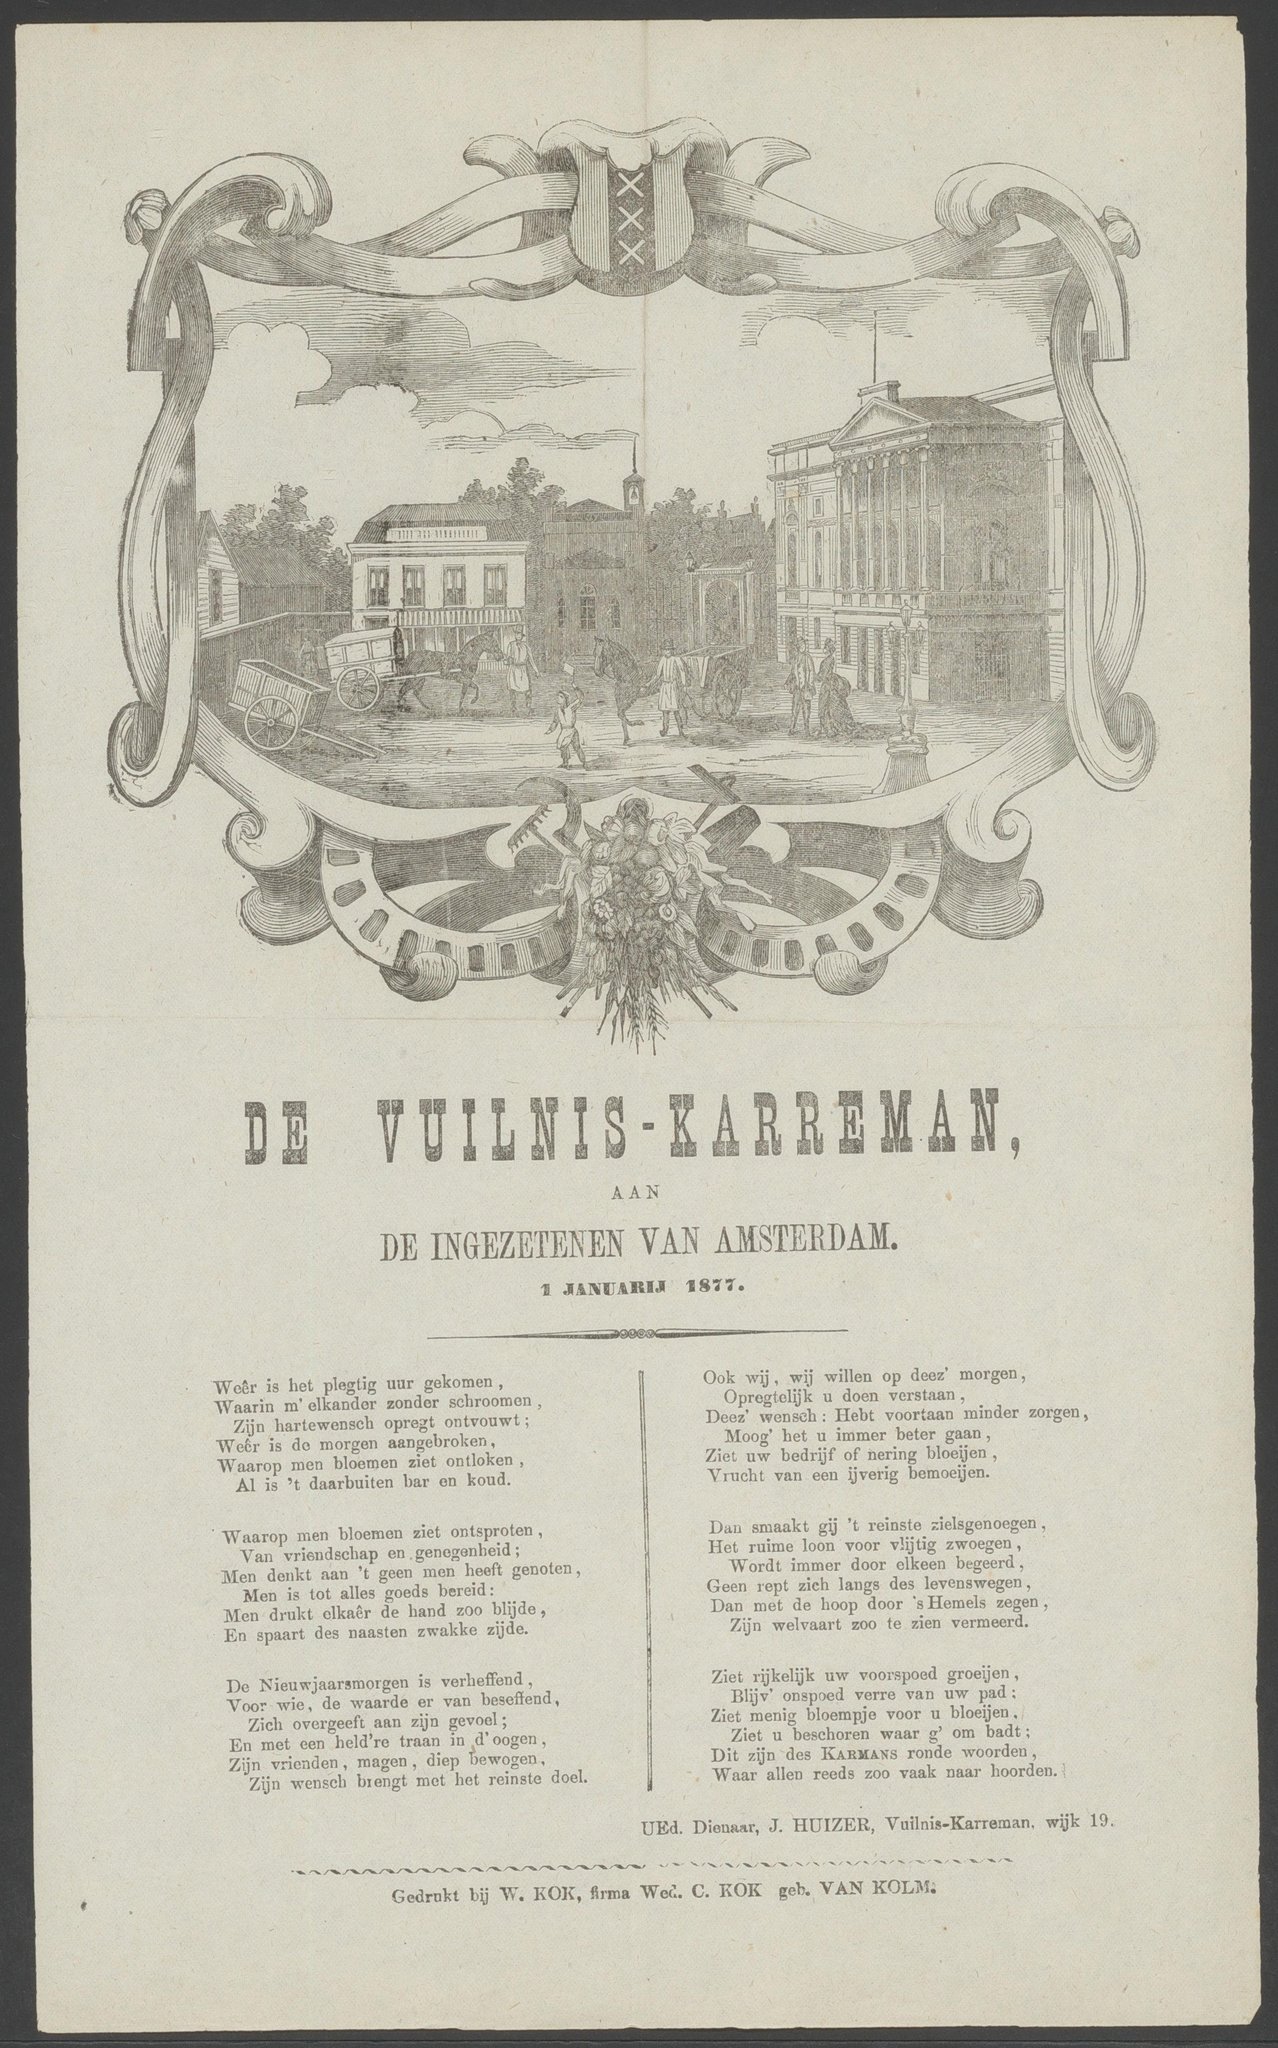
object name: print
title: Kermisprent van de vuilnismannen van Amsterdam voor het jaar 1877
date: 1877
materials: paper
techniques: letterpress printing, engraving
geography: amsterdam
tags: street, garbage collection, amsterdam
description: Kermisprent van de Amsterdamse vuilnismannen voor het jaar 1877. Vuilnismannen met hun karren op een plein. Met gedicht in twee kolommen. Van de vuilniskarman in de wijk no. 19: J. Huizer. Onderwerpsrubrieken binnen de Atlas Zeden en Gewoonten: Zeden en gewoonten in engeren zin, Volksleven, Volksbladen, Nieuwjaars- en Kerstwenschen, Amsterdam.